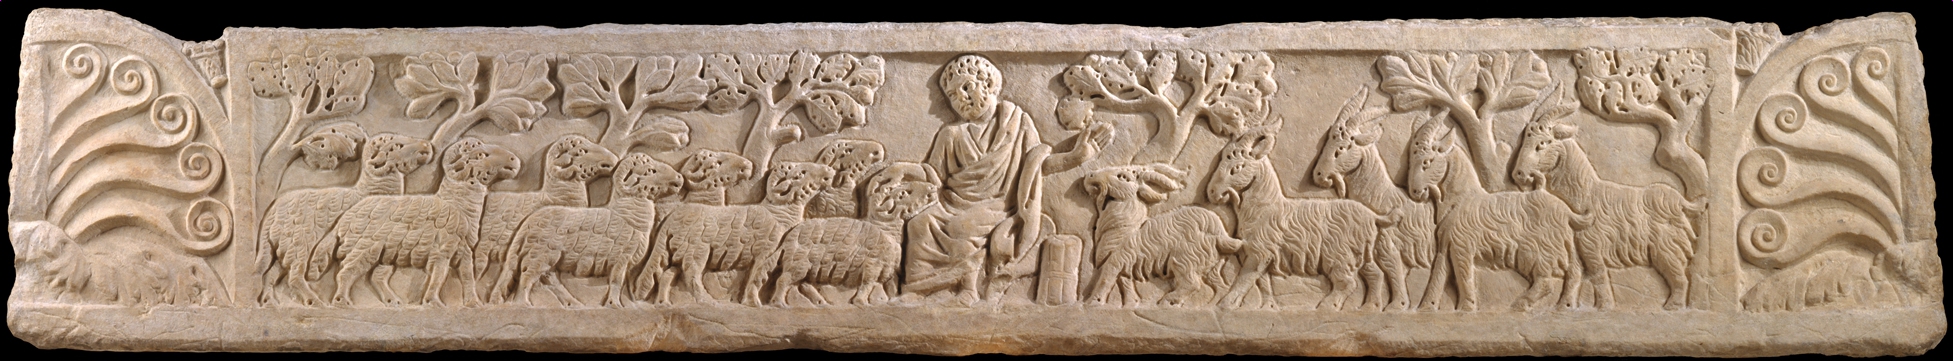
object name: sarcophagus lid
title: Sarcophagus Lid with Last Judgement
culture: roman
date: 267-333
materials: marble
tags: goats,sheep,christ